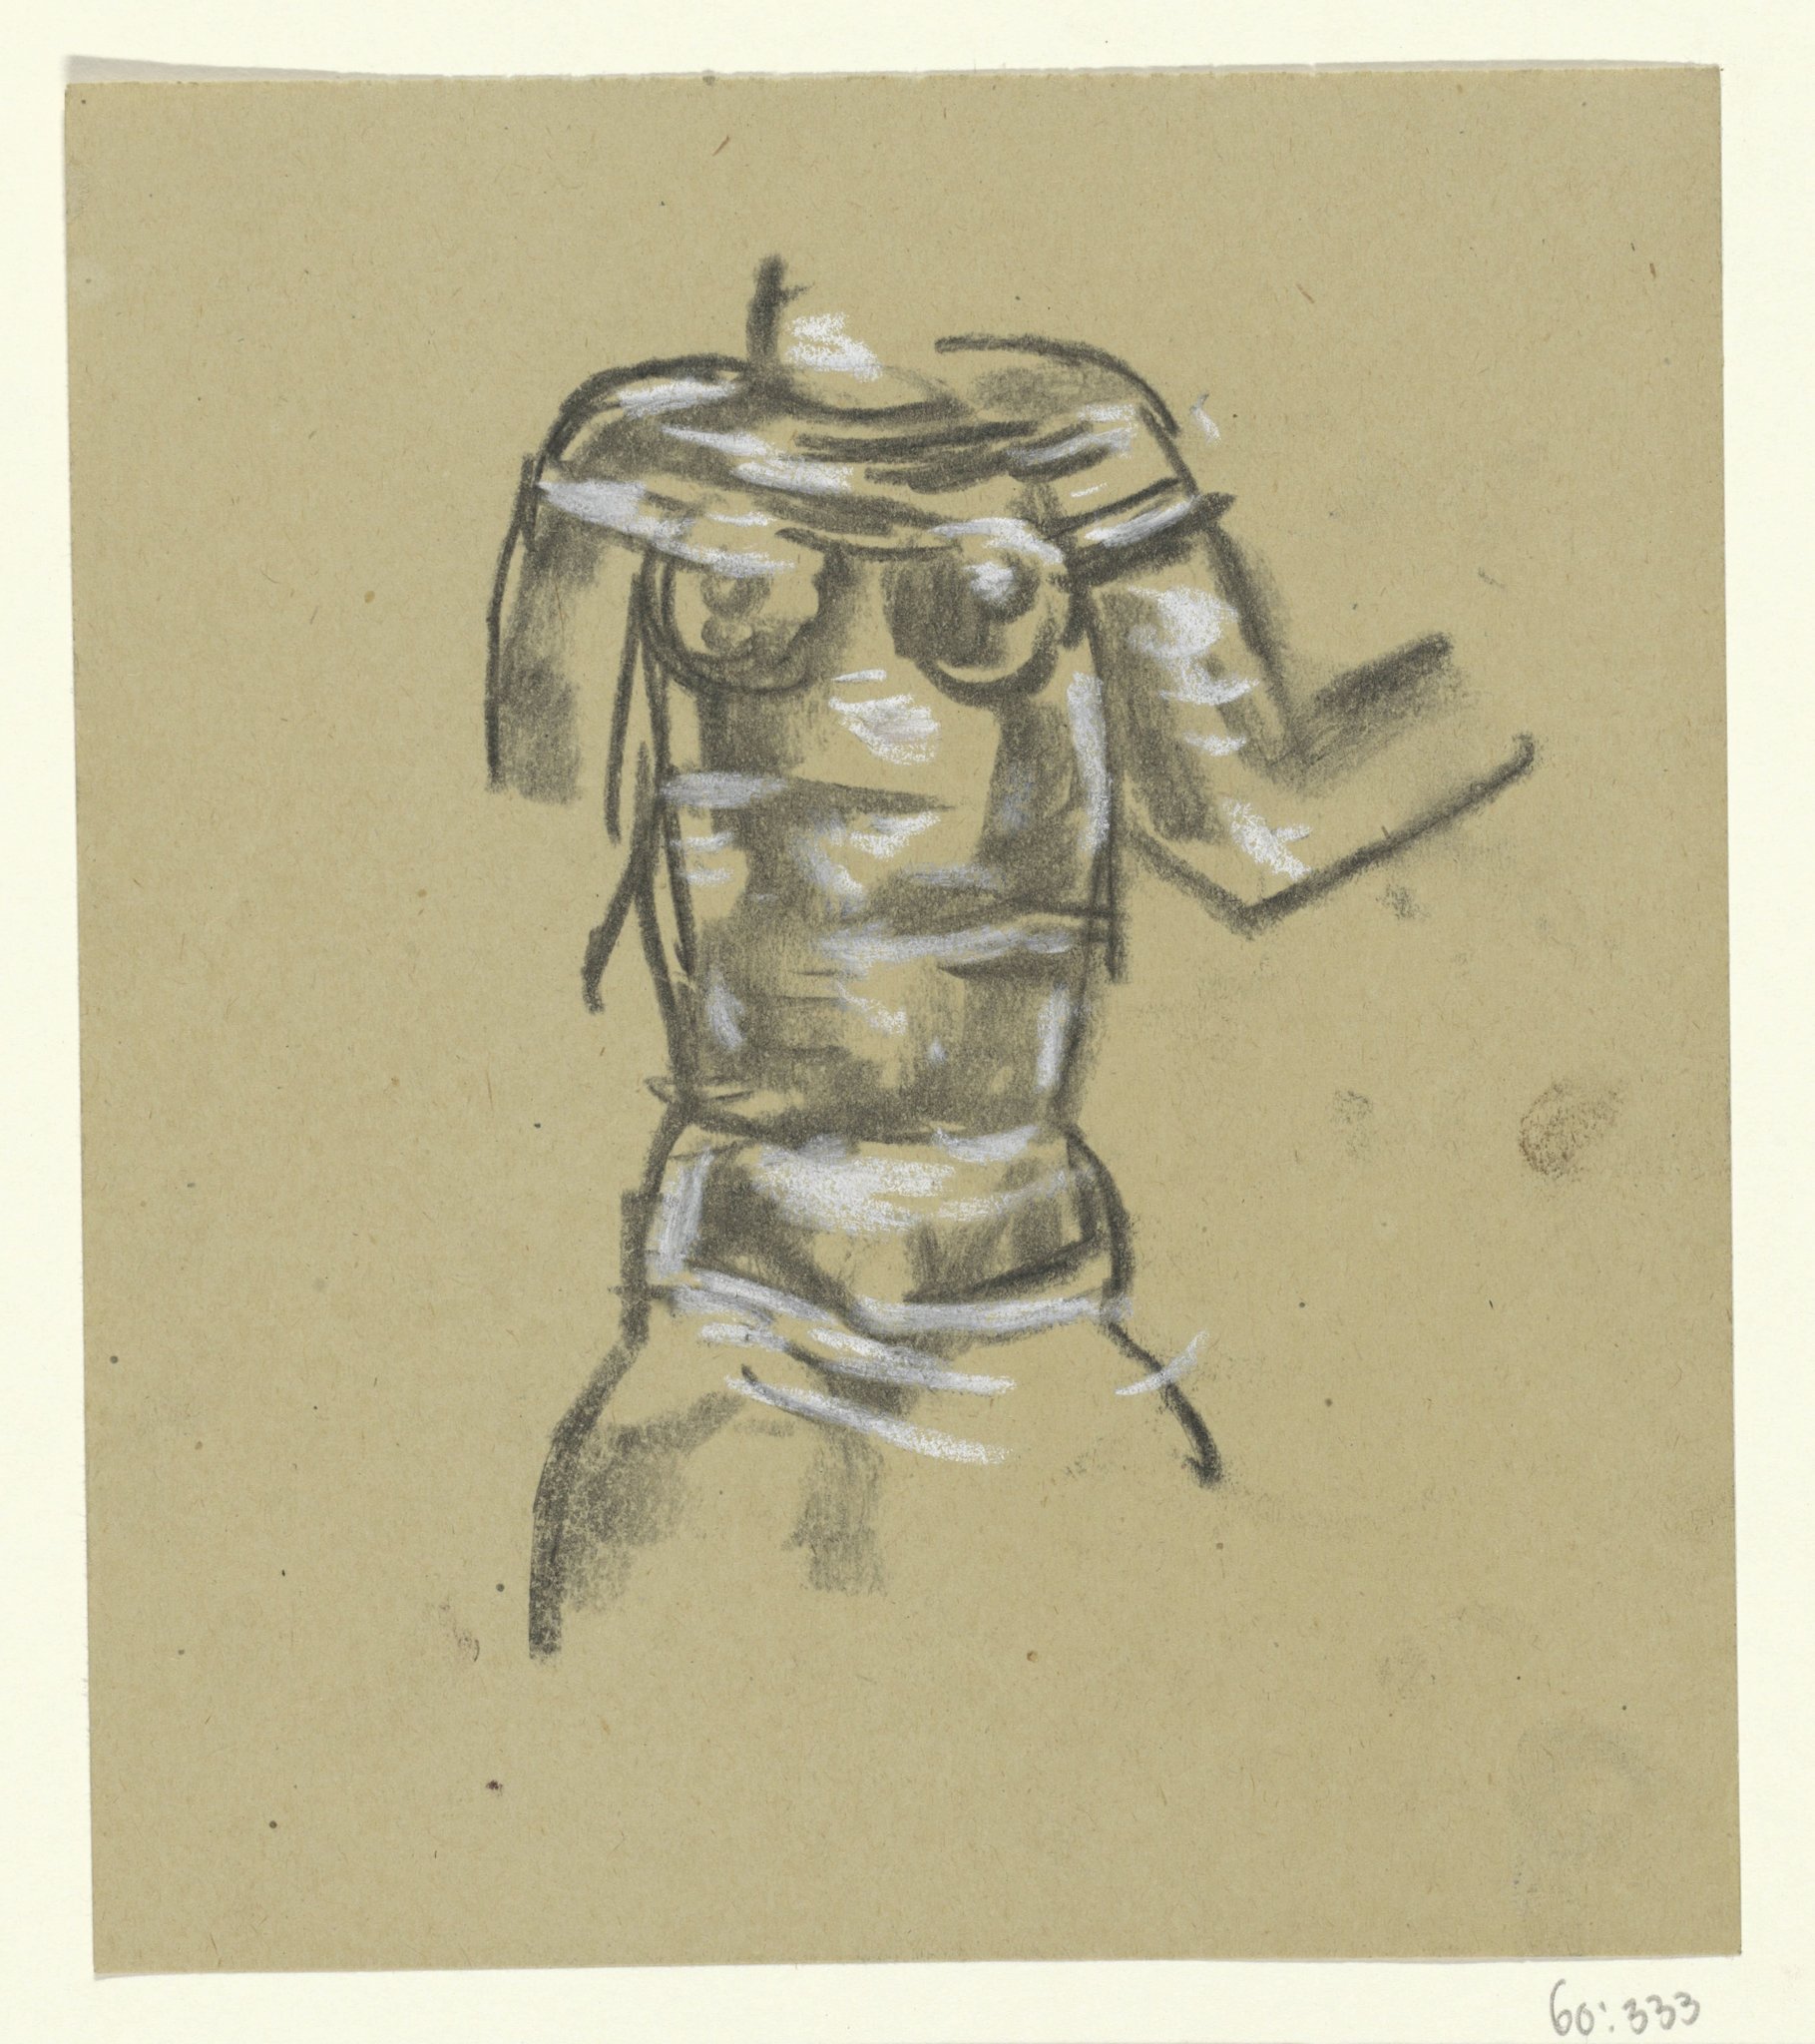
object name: drawing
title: Torso van een vrouw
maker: leo gestel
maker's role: draughtsman, print maker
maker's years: 1881-1941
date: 1891-1941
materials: chalk, paper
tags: female sex; woman (+ nude human being)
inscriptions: collector's mark: Lugt 2228